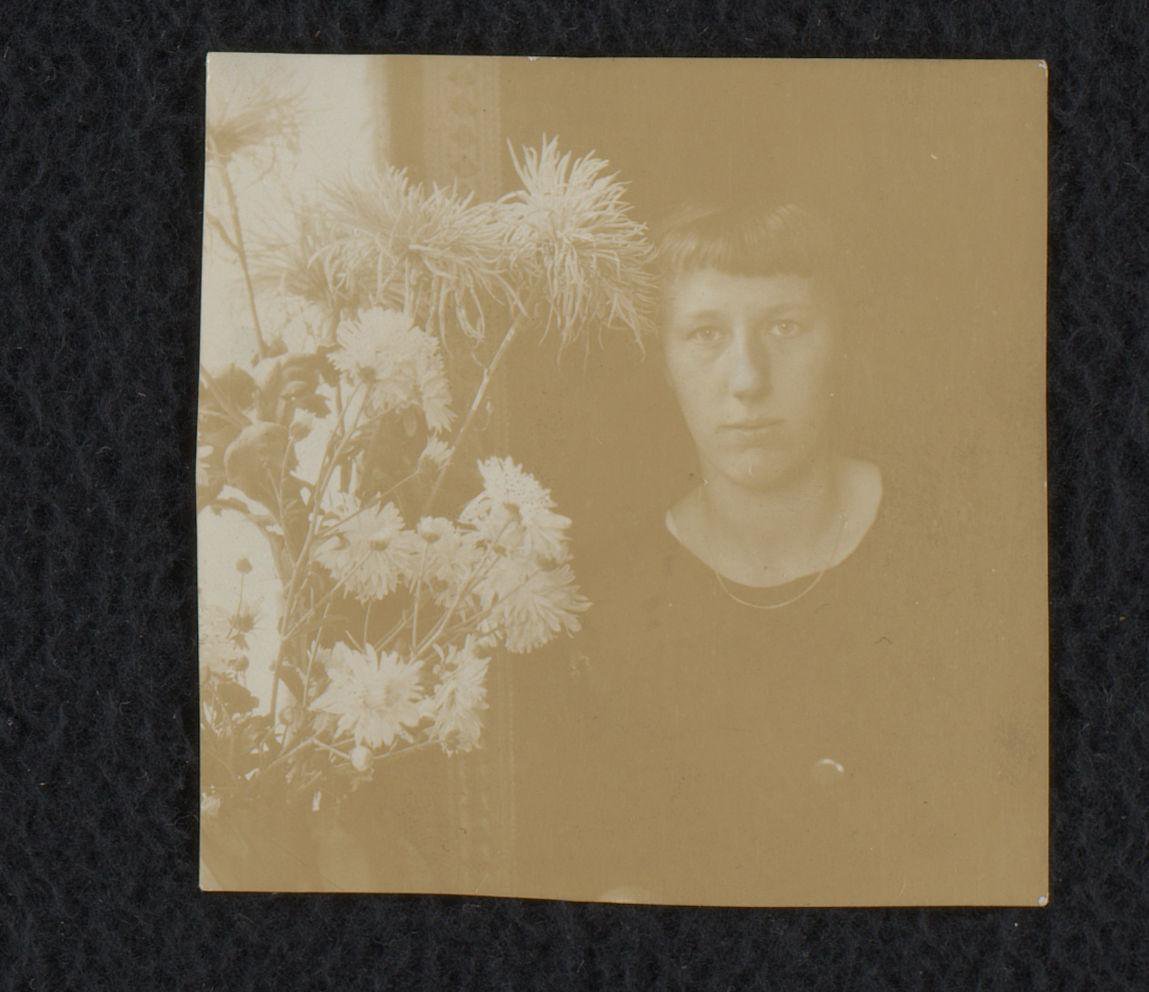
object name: photograph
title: Portret van een onbekende jonge vrouw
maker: carolina frederika onnen (lien/loen)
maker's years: 1896-1983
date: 1912-1913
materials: paper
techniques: collodion silver print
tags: anonymous historical person portrayed - bb - woman